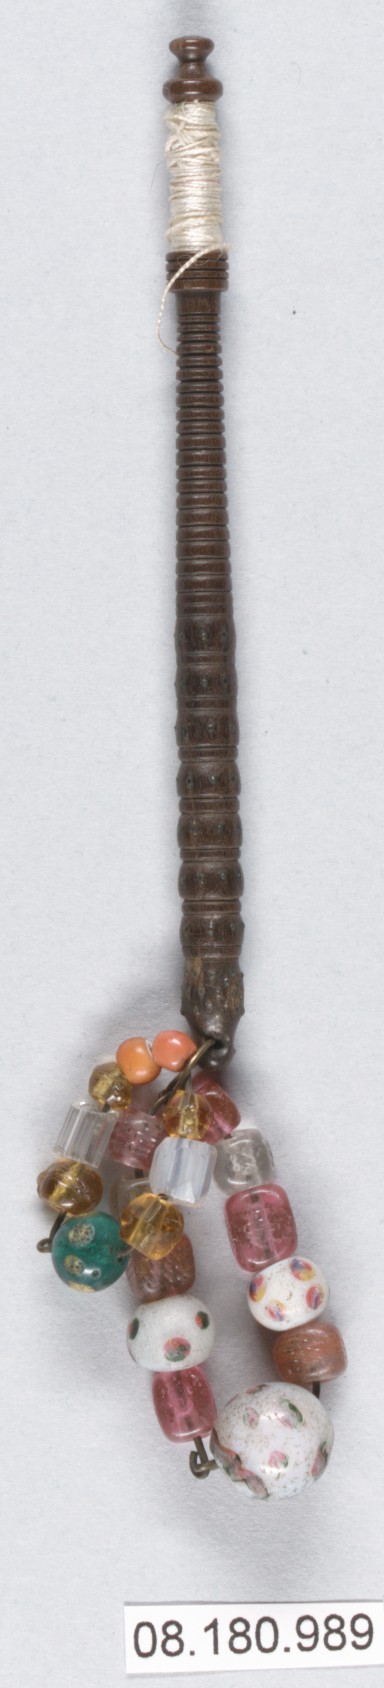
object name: bobbin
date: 1801-1900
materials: metal, wood